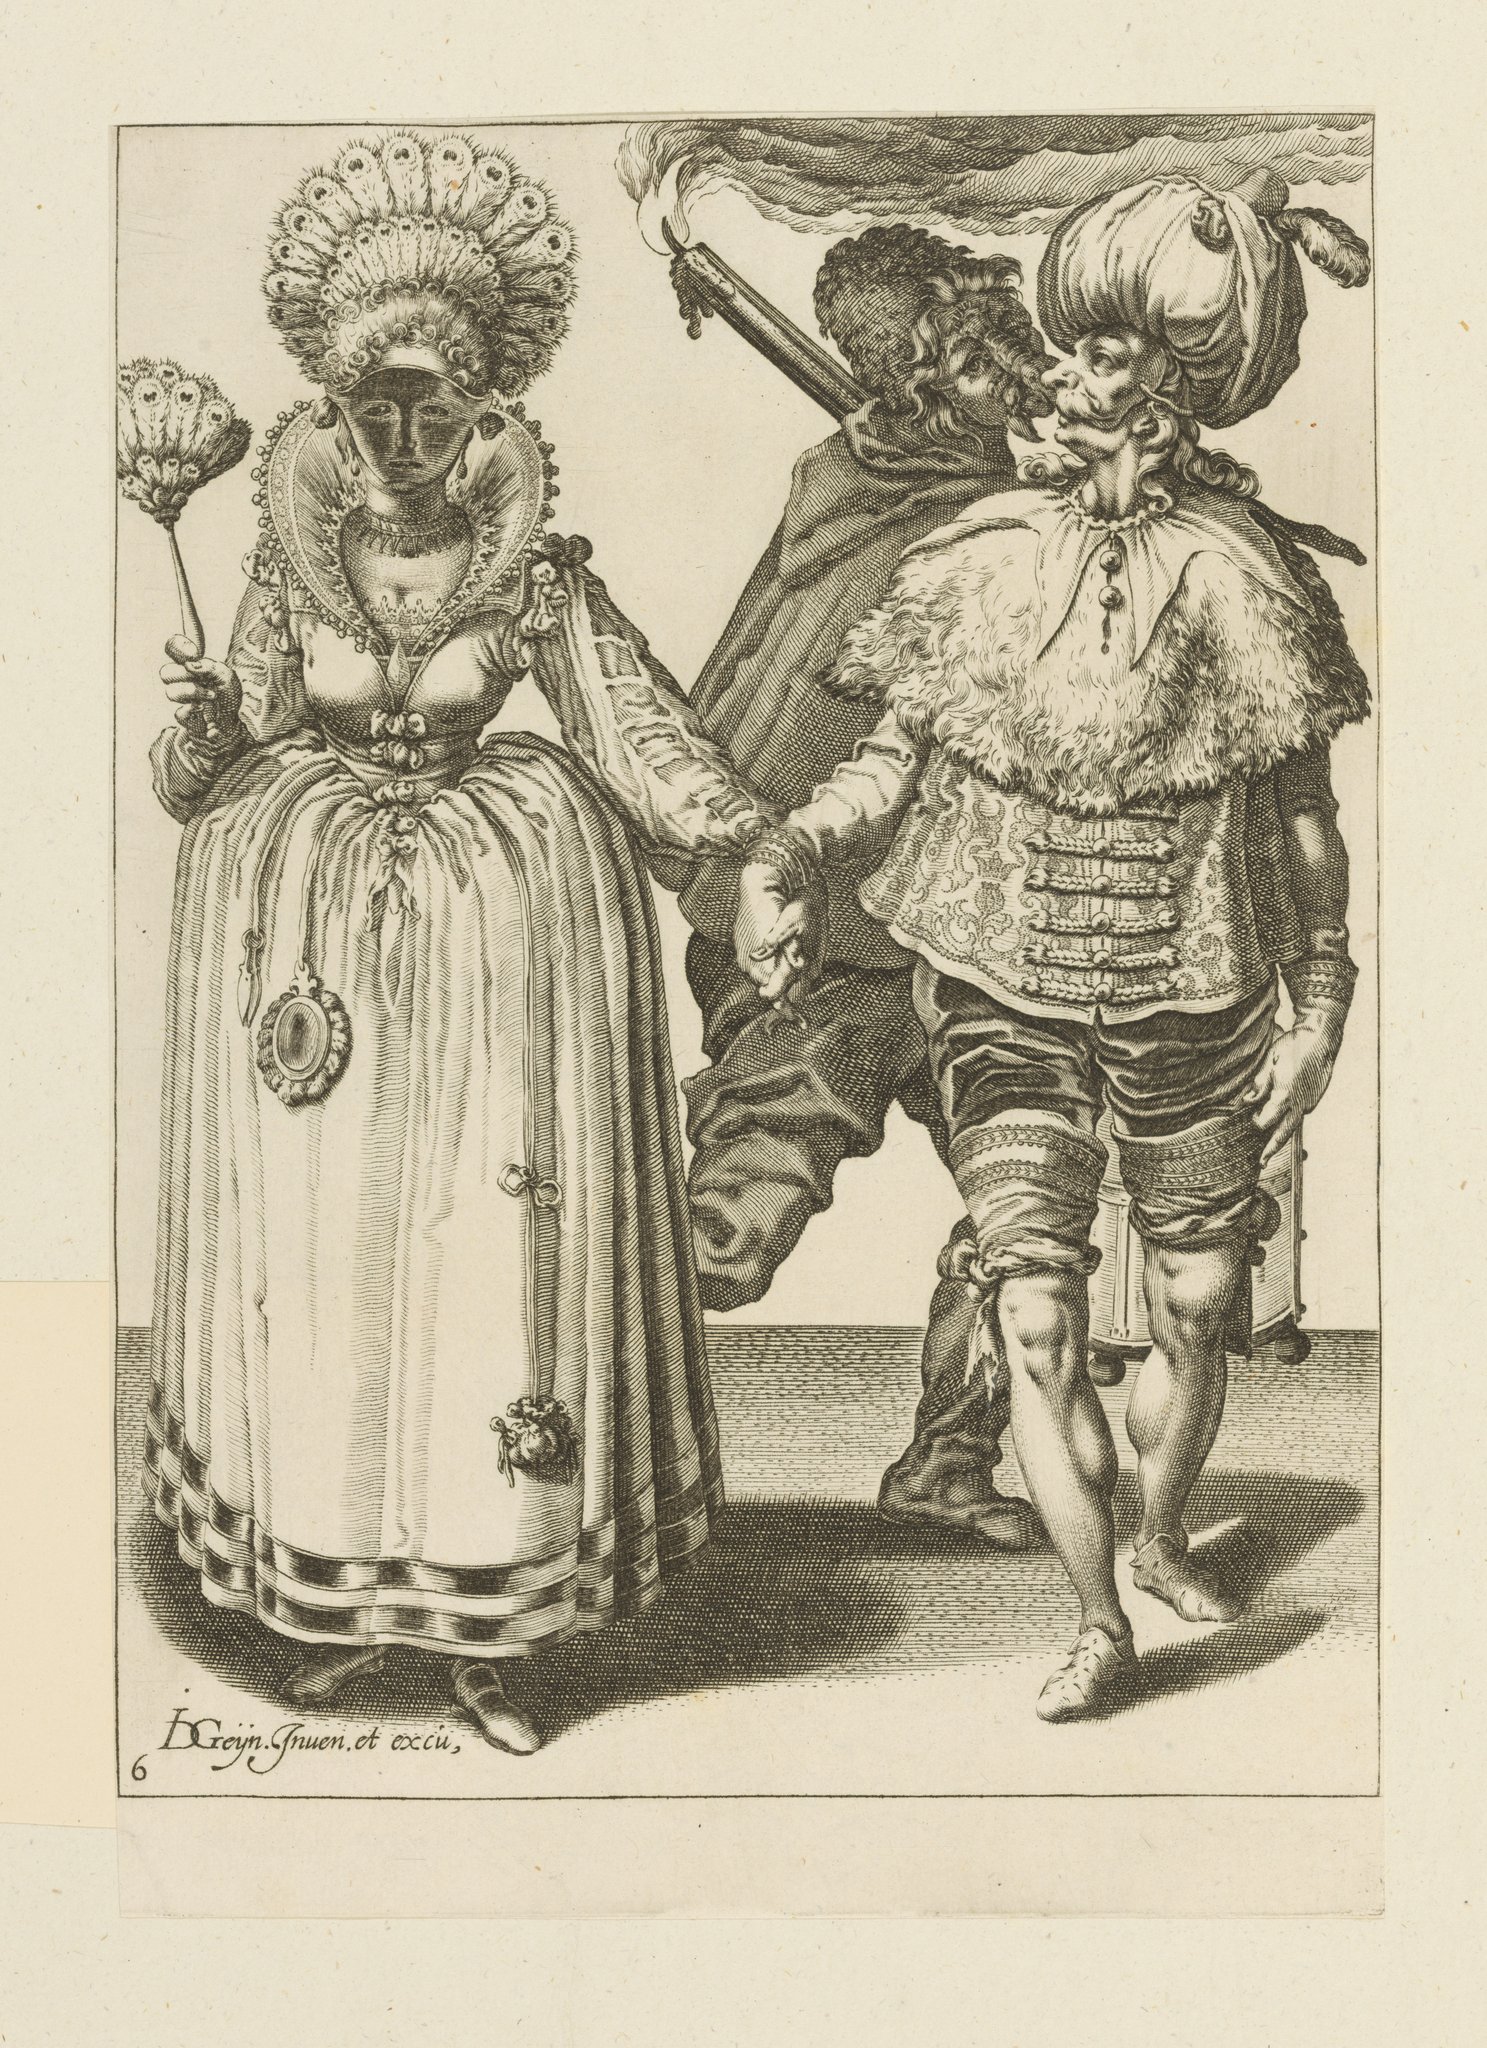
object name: print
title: A Man with a Turban Leading a Woman by the Hand, Behind Them a Torchbearer, plate 6 from "The Masquerades"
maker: jacques de gheyn (ii)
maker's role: artist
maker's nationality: netherlandish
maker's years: 1565-1629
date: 1595-1596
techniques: engraving